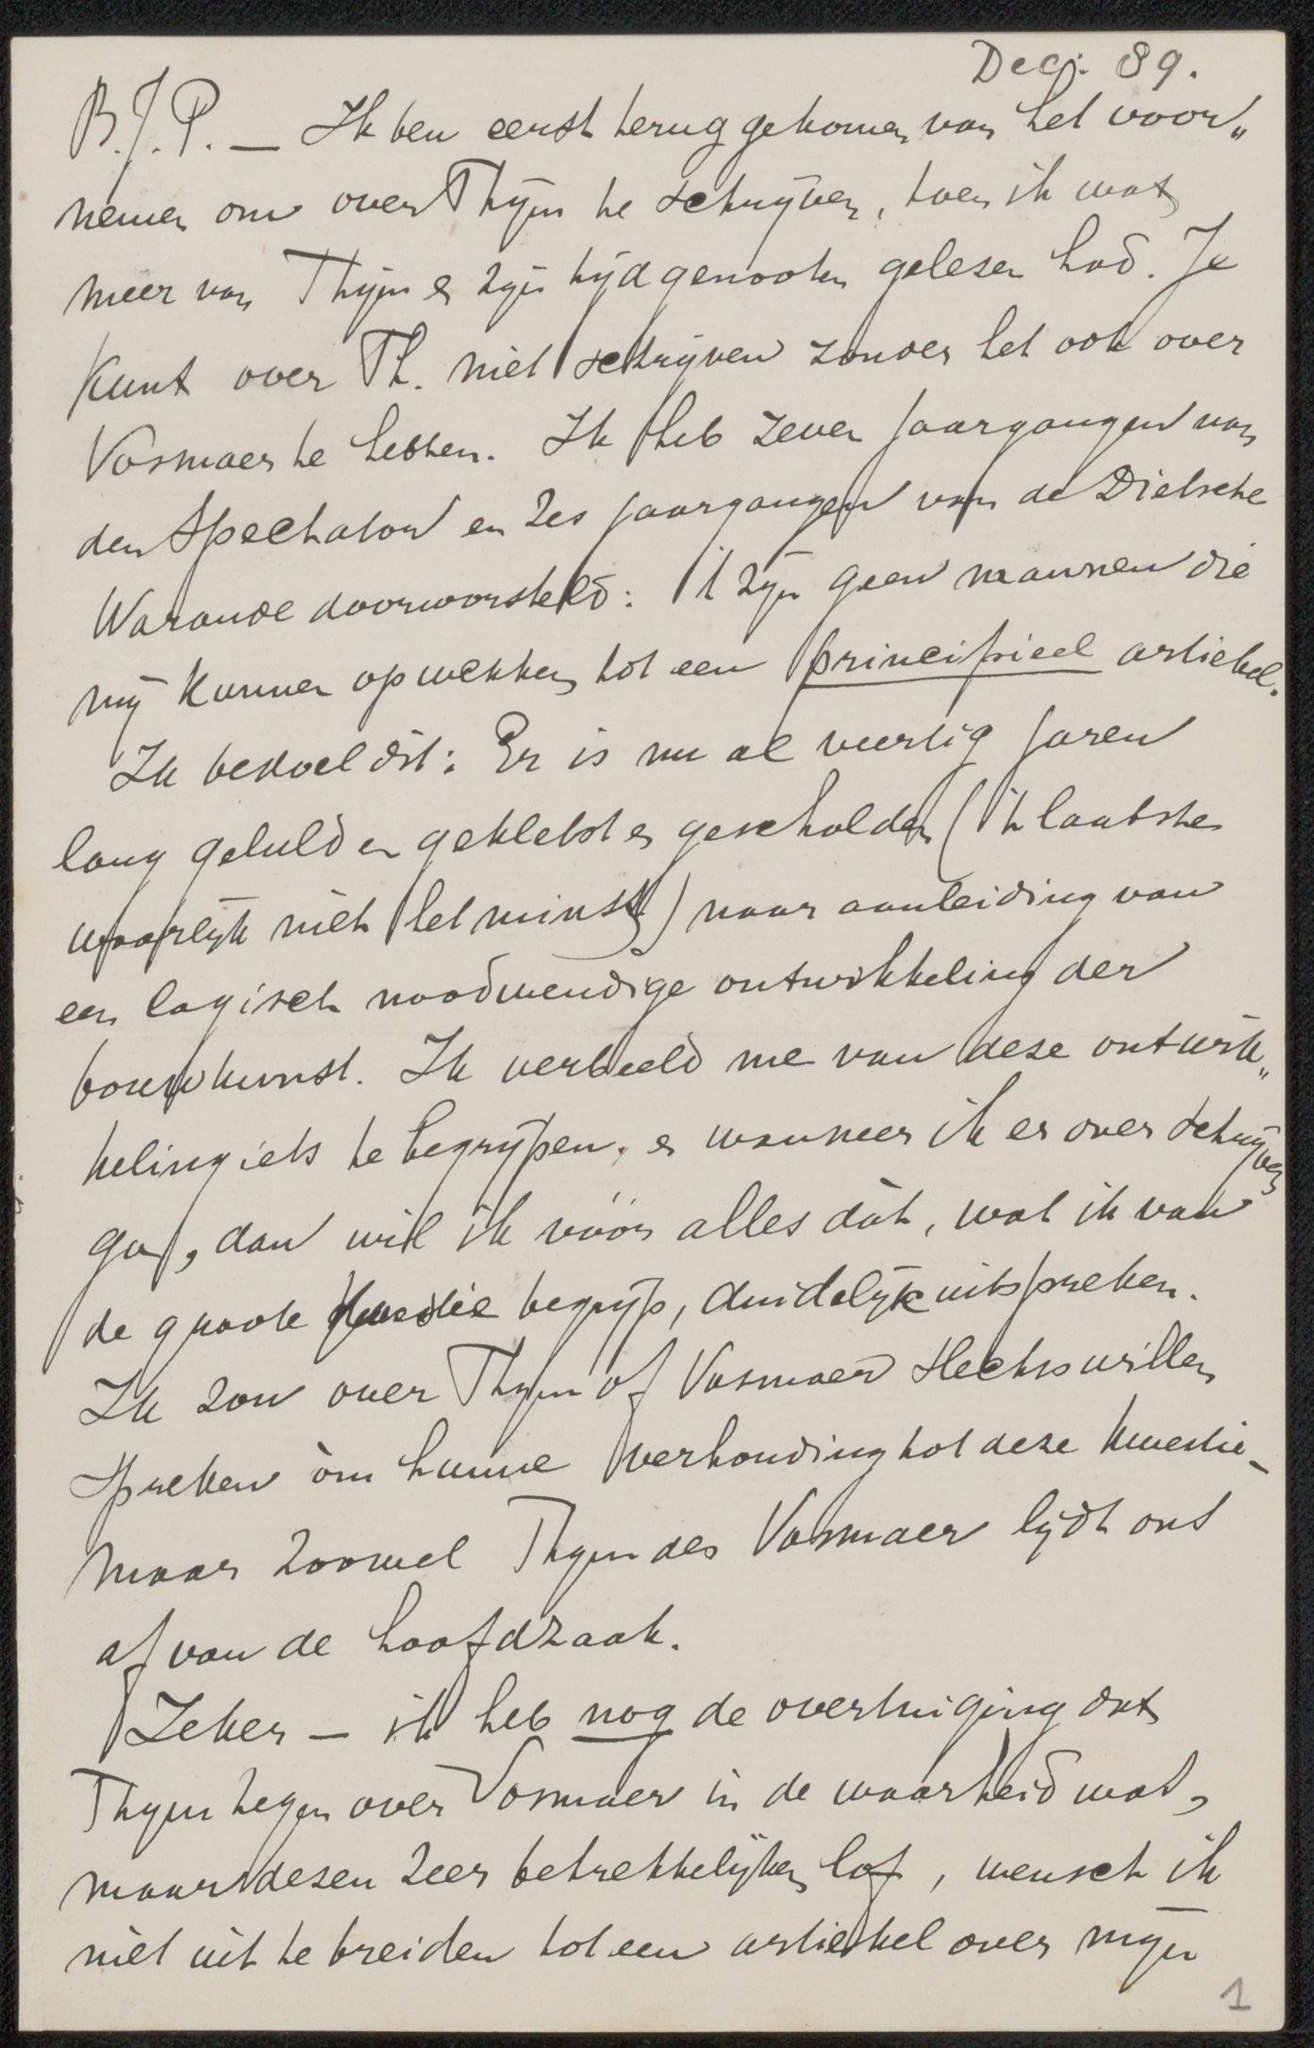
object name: letter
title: Brief aan Jan Veth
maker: antoon derkinderen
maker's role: draughtsman, painter, print maker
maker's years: 1859-1925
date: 1874-1925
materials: ink, paper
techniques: pen, writing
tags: designer, jan veth, carel vosmaer, amsterdam, painter, draughtsman, publisher, josephus albertus alberdingk thijm, paris, conservator, eugène emmanuel viollet-le-duc, architecture, printed matter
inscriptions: collector's mark: ‘RPK’